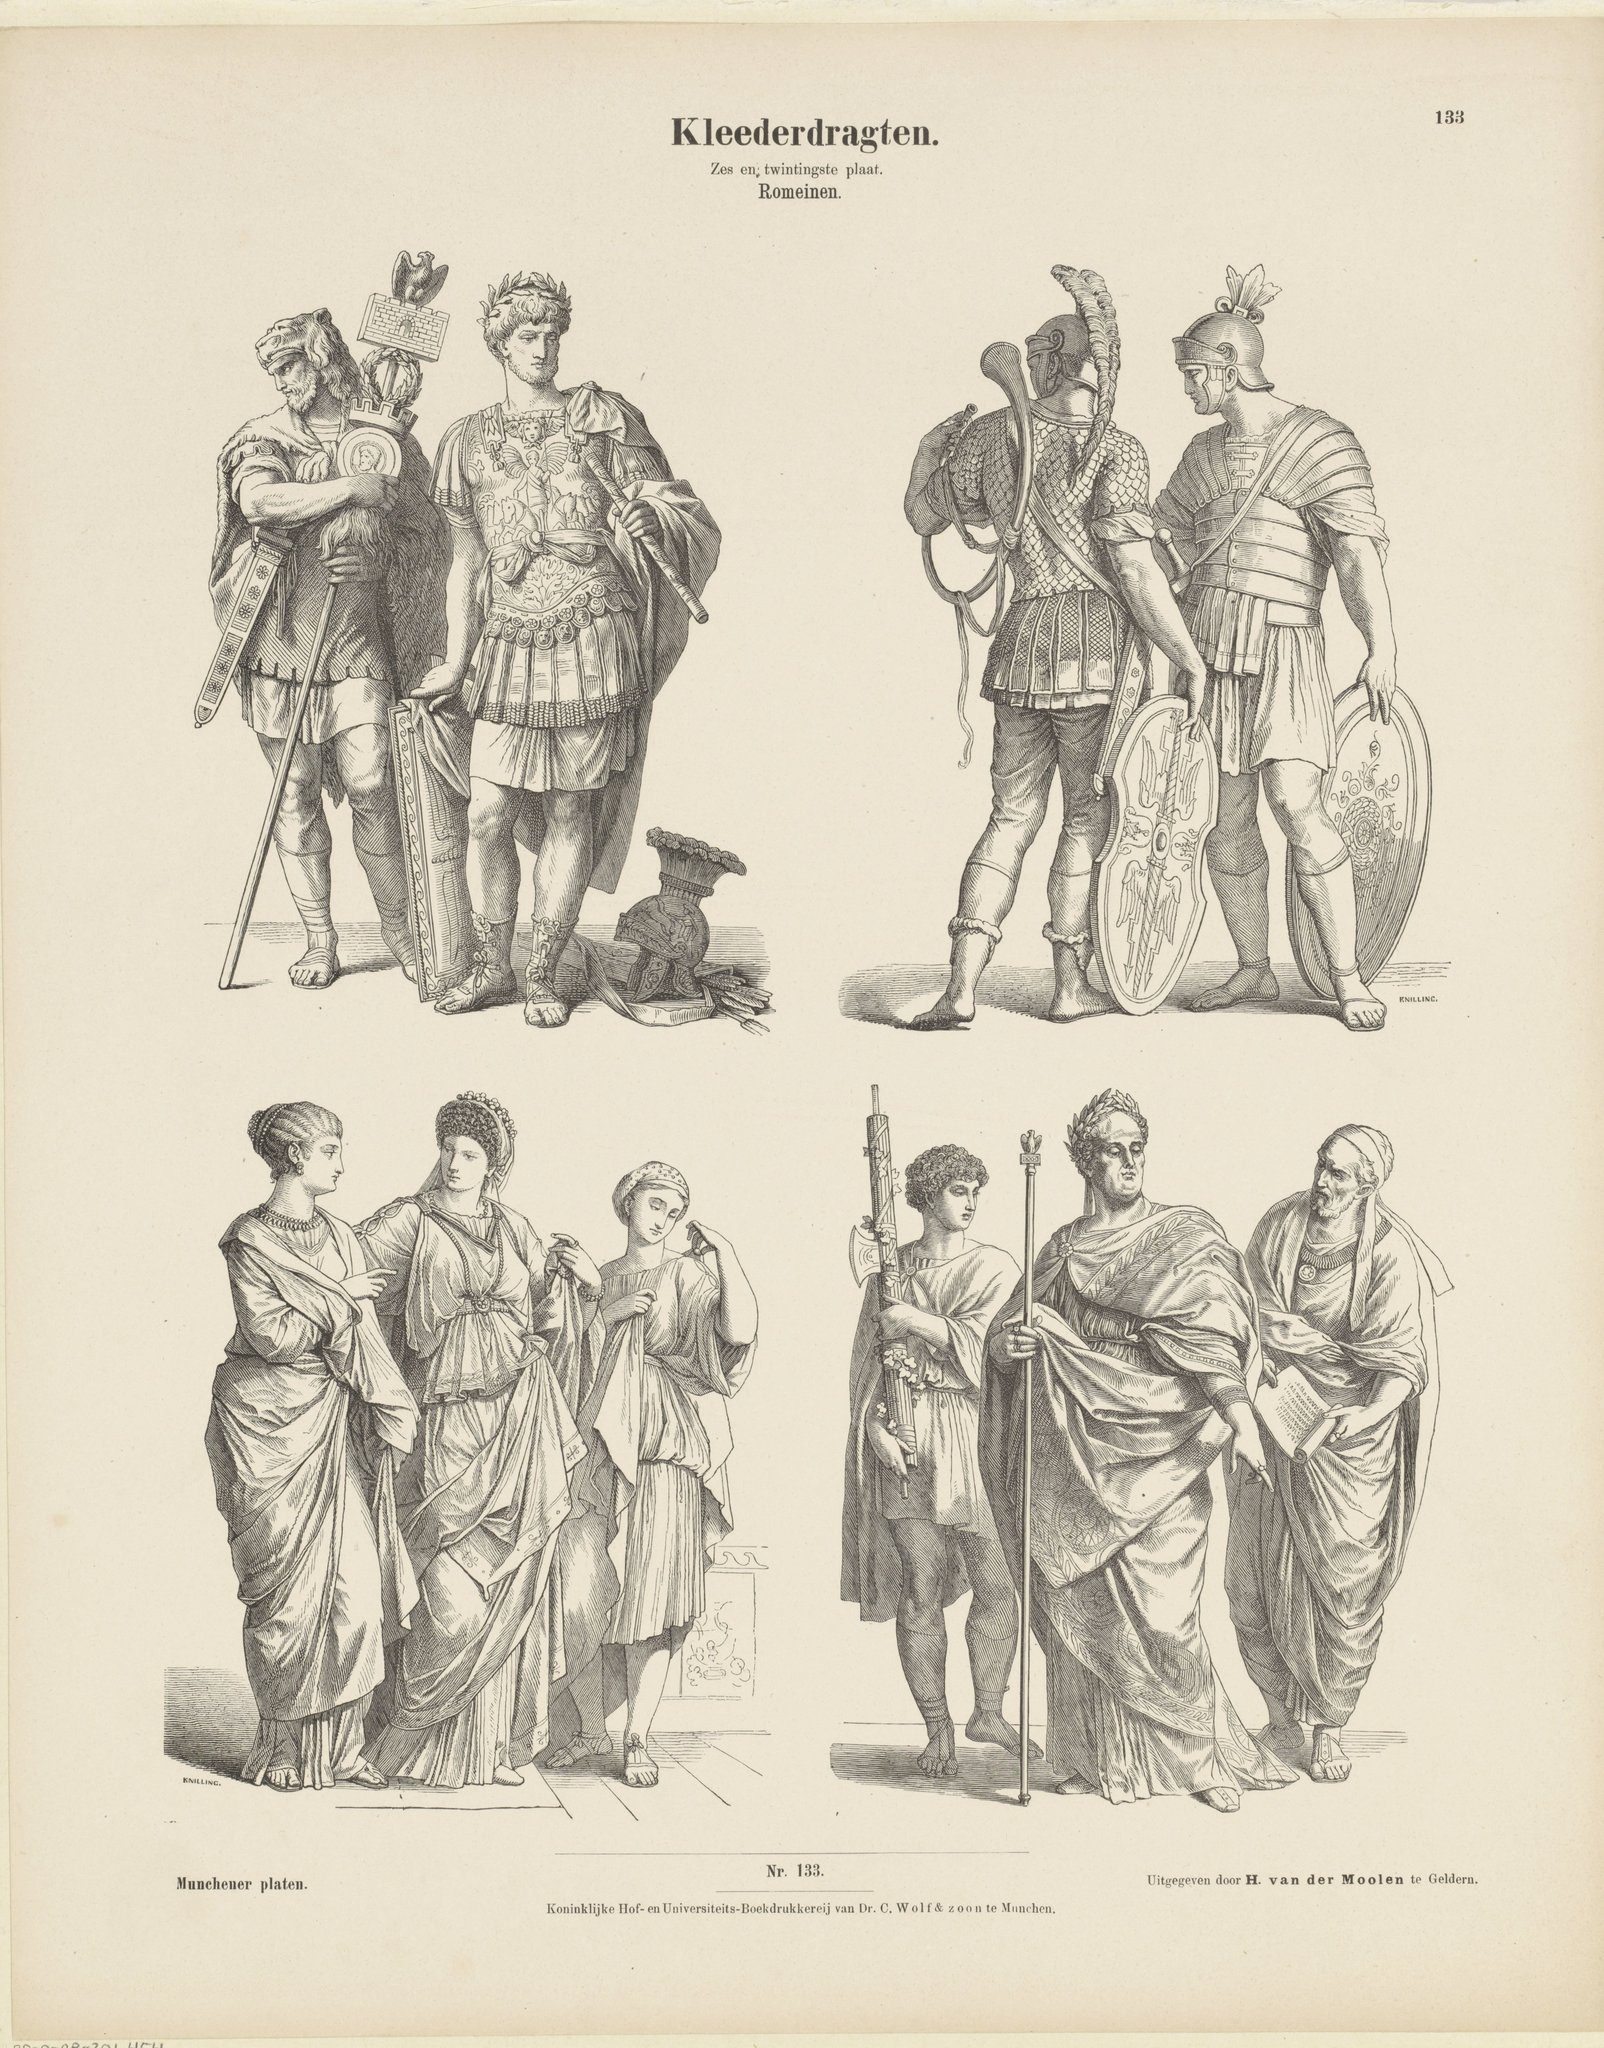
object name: print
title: Kleederdragten / Zes en twintigste plaat. / Romeinen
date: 1843-1920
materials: paper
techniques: letterpress printing, engraving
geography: geldern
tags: historical costume, folk costume, regional costume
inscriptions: collector's mark: Lugt 2760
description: Nederlandse editie van een prent uit de reeks "Munchener platen" uitgegeven door K. Braun & Fr. Schneider te München met het adres van wederverkoper Hermann van der Moolen.